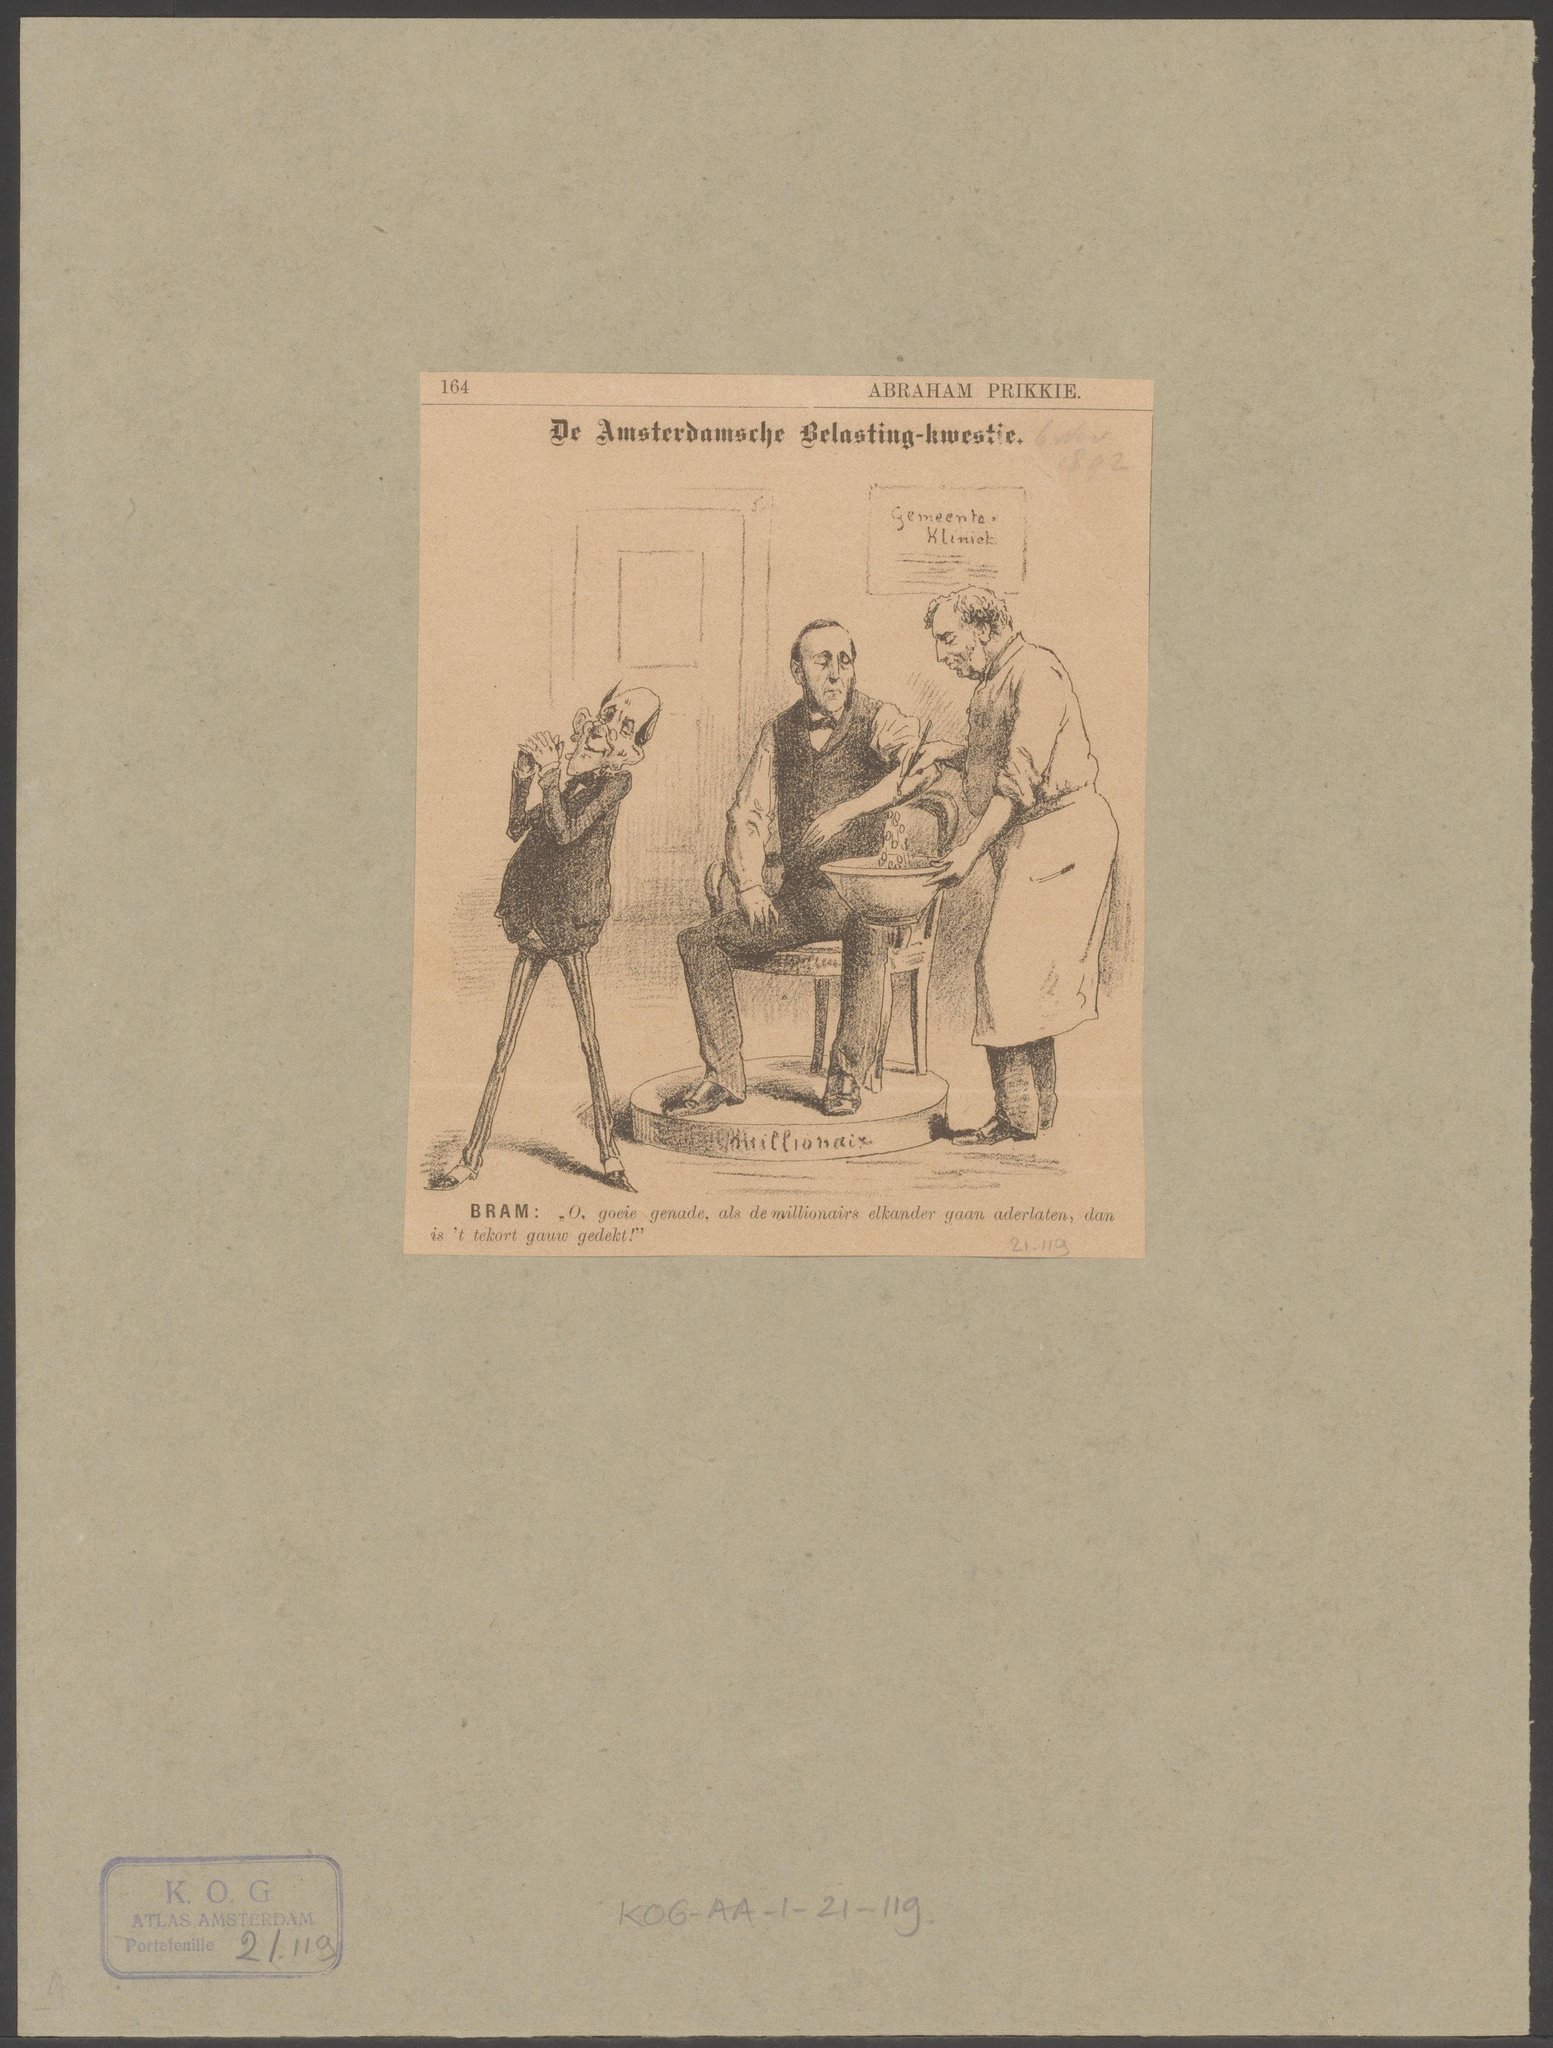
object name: newspaper clipping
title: De Amsterdamsche Belasting-kwestie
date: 1892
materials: paper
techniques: letterpress printing, lithograph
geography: rotterdam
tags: harlingen, politician, bleeding, blood-letting, e.g.: with the aid of cupping-glasses, mayor, burgomaster, tax payment, municipal government, taxes and financial administration, political caricatures and satires, amsterdam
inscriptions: collector's mark: Lugt 1641b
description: Burgemeester van Amsterdam Vening Meinesz als patiënt, Abraham Mozes Reens als behandelaar en links Abraham Prikkie. Onderwerpsrubriek binnen de Atlas Amsterdam: Belastingen.